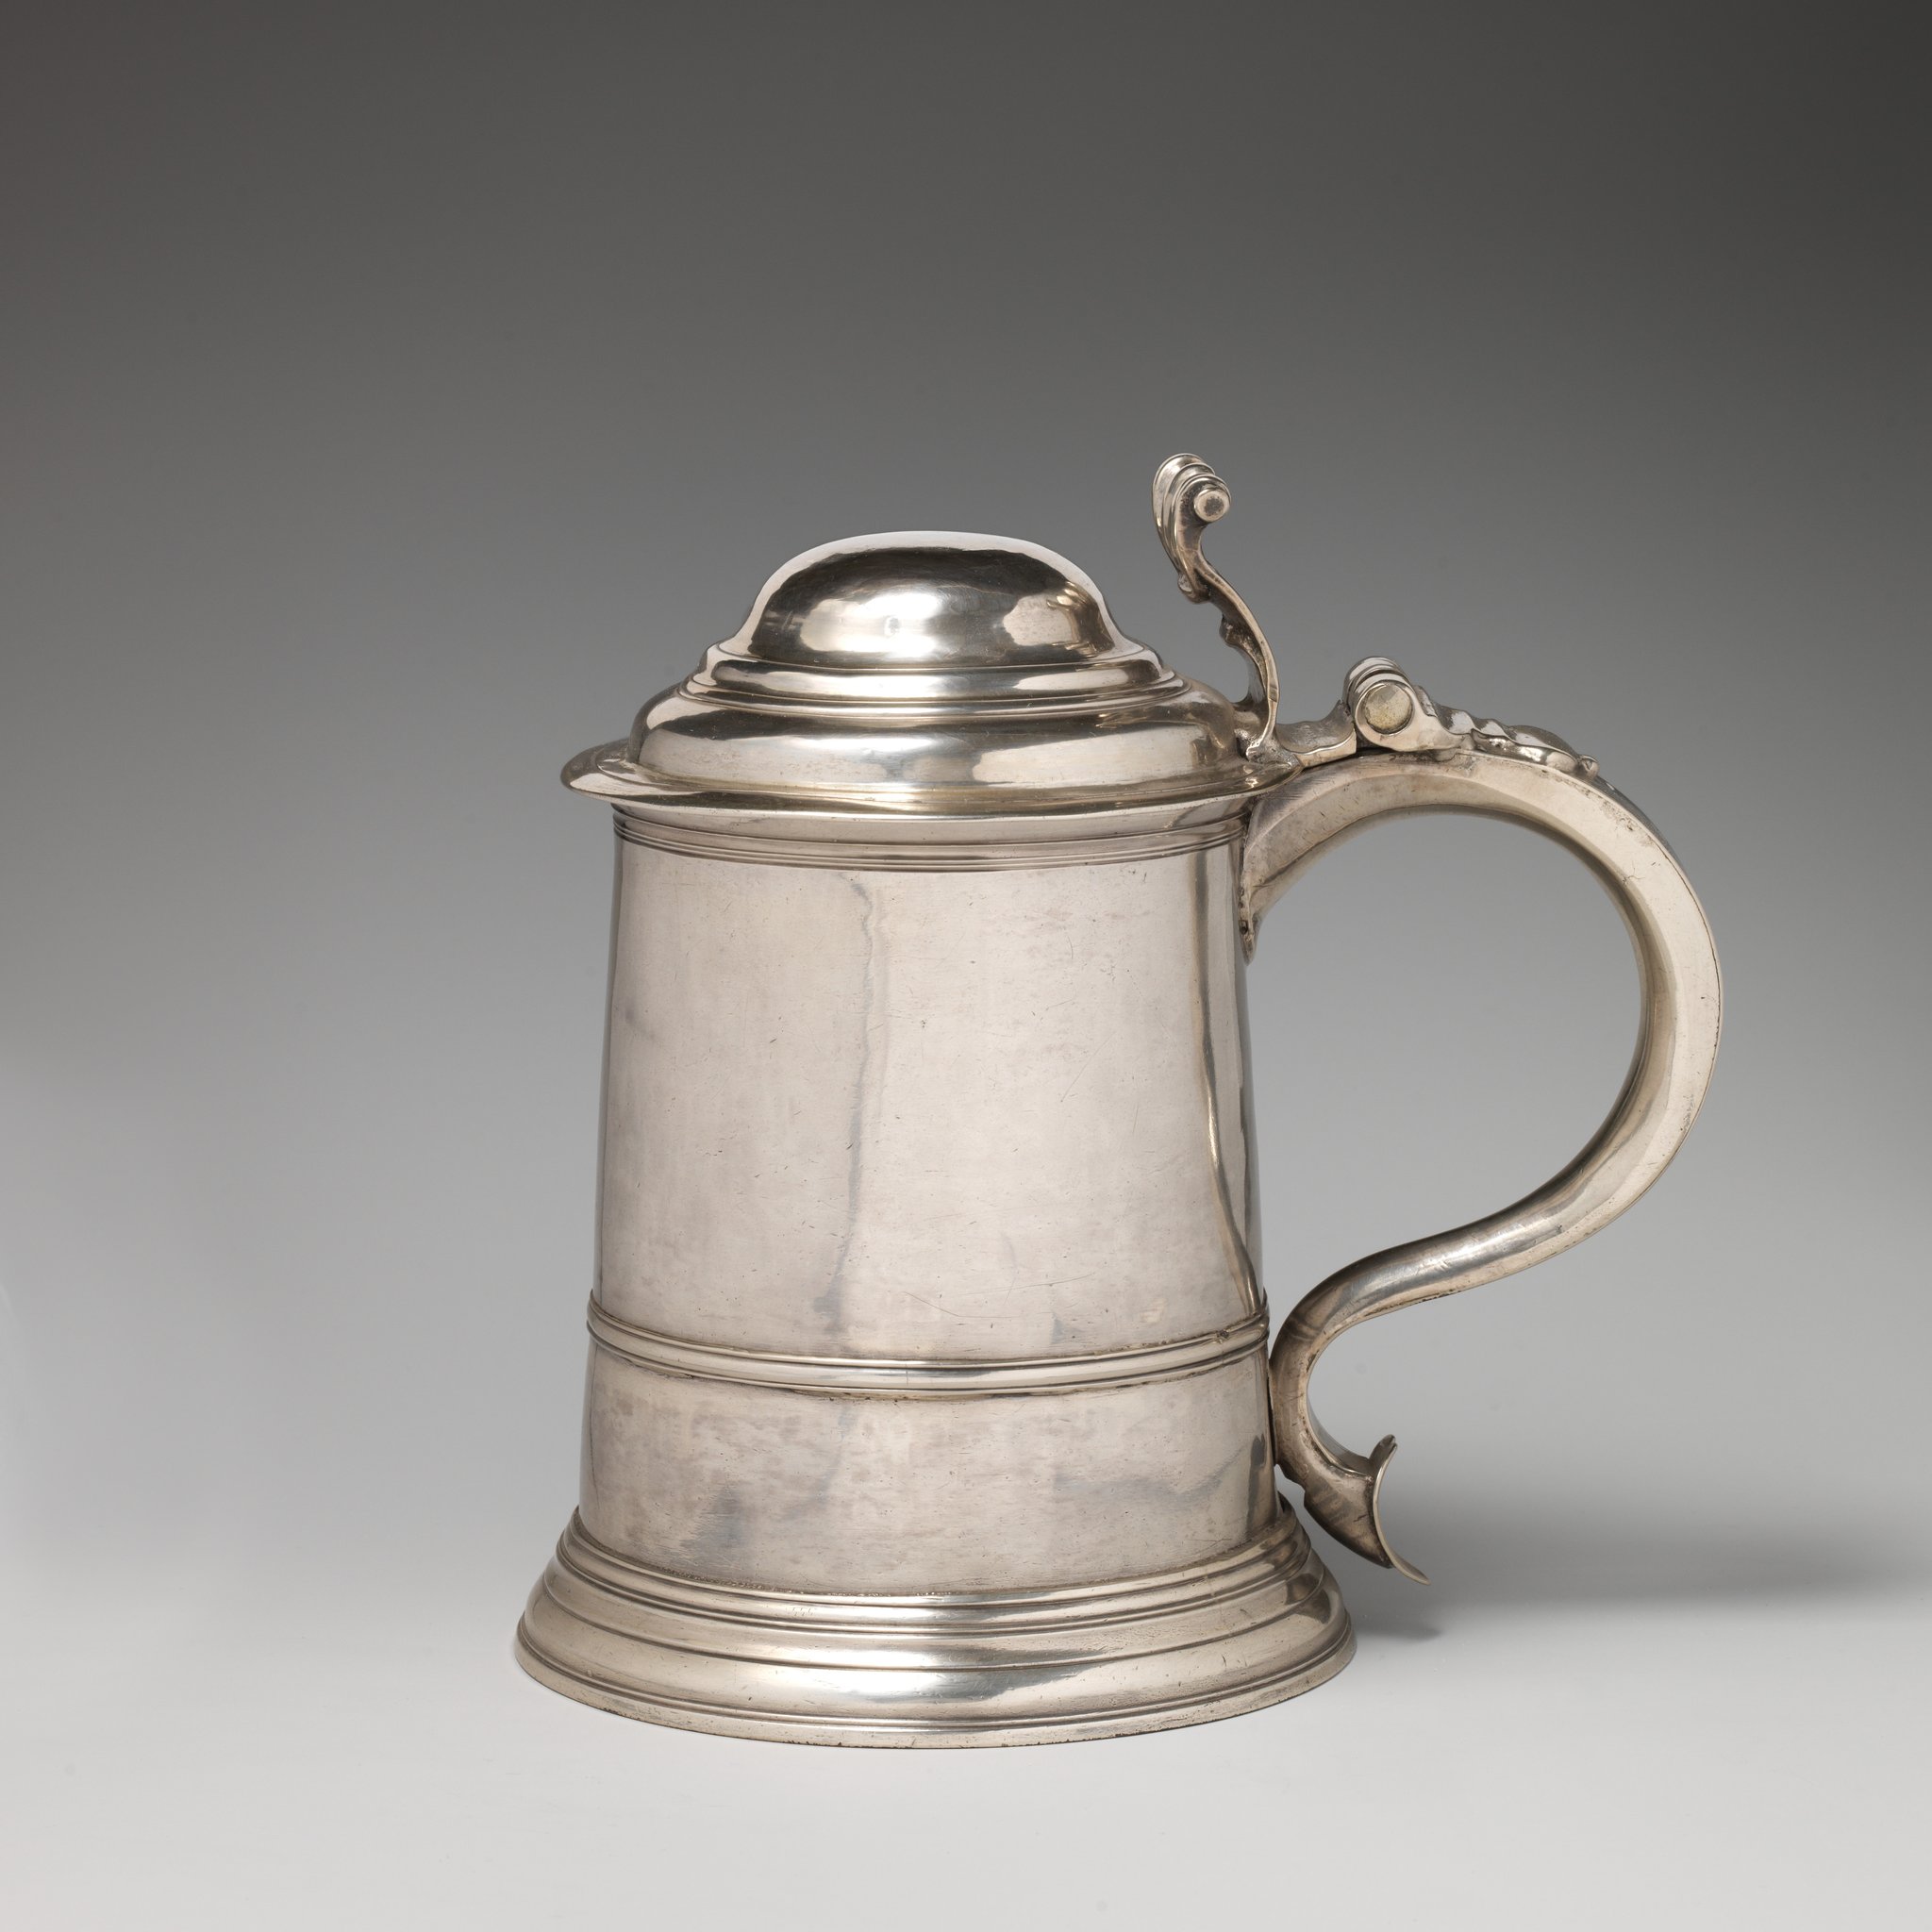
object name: tankard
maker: richard gurney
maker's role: maker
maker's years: 1727-1773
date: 1733-1734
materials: silver